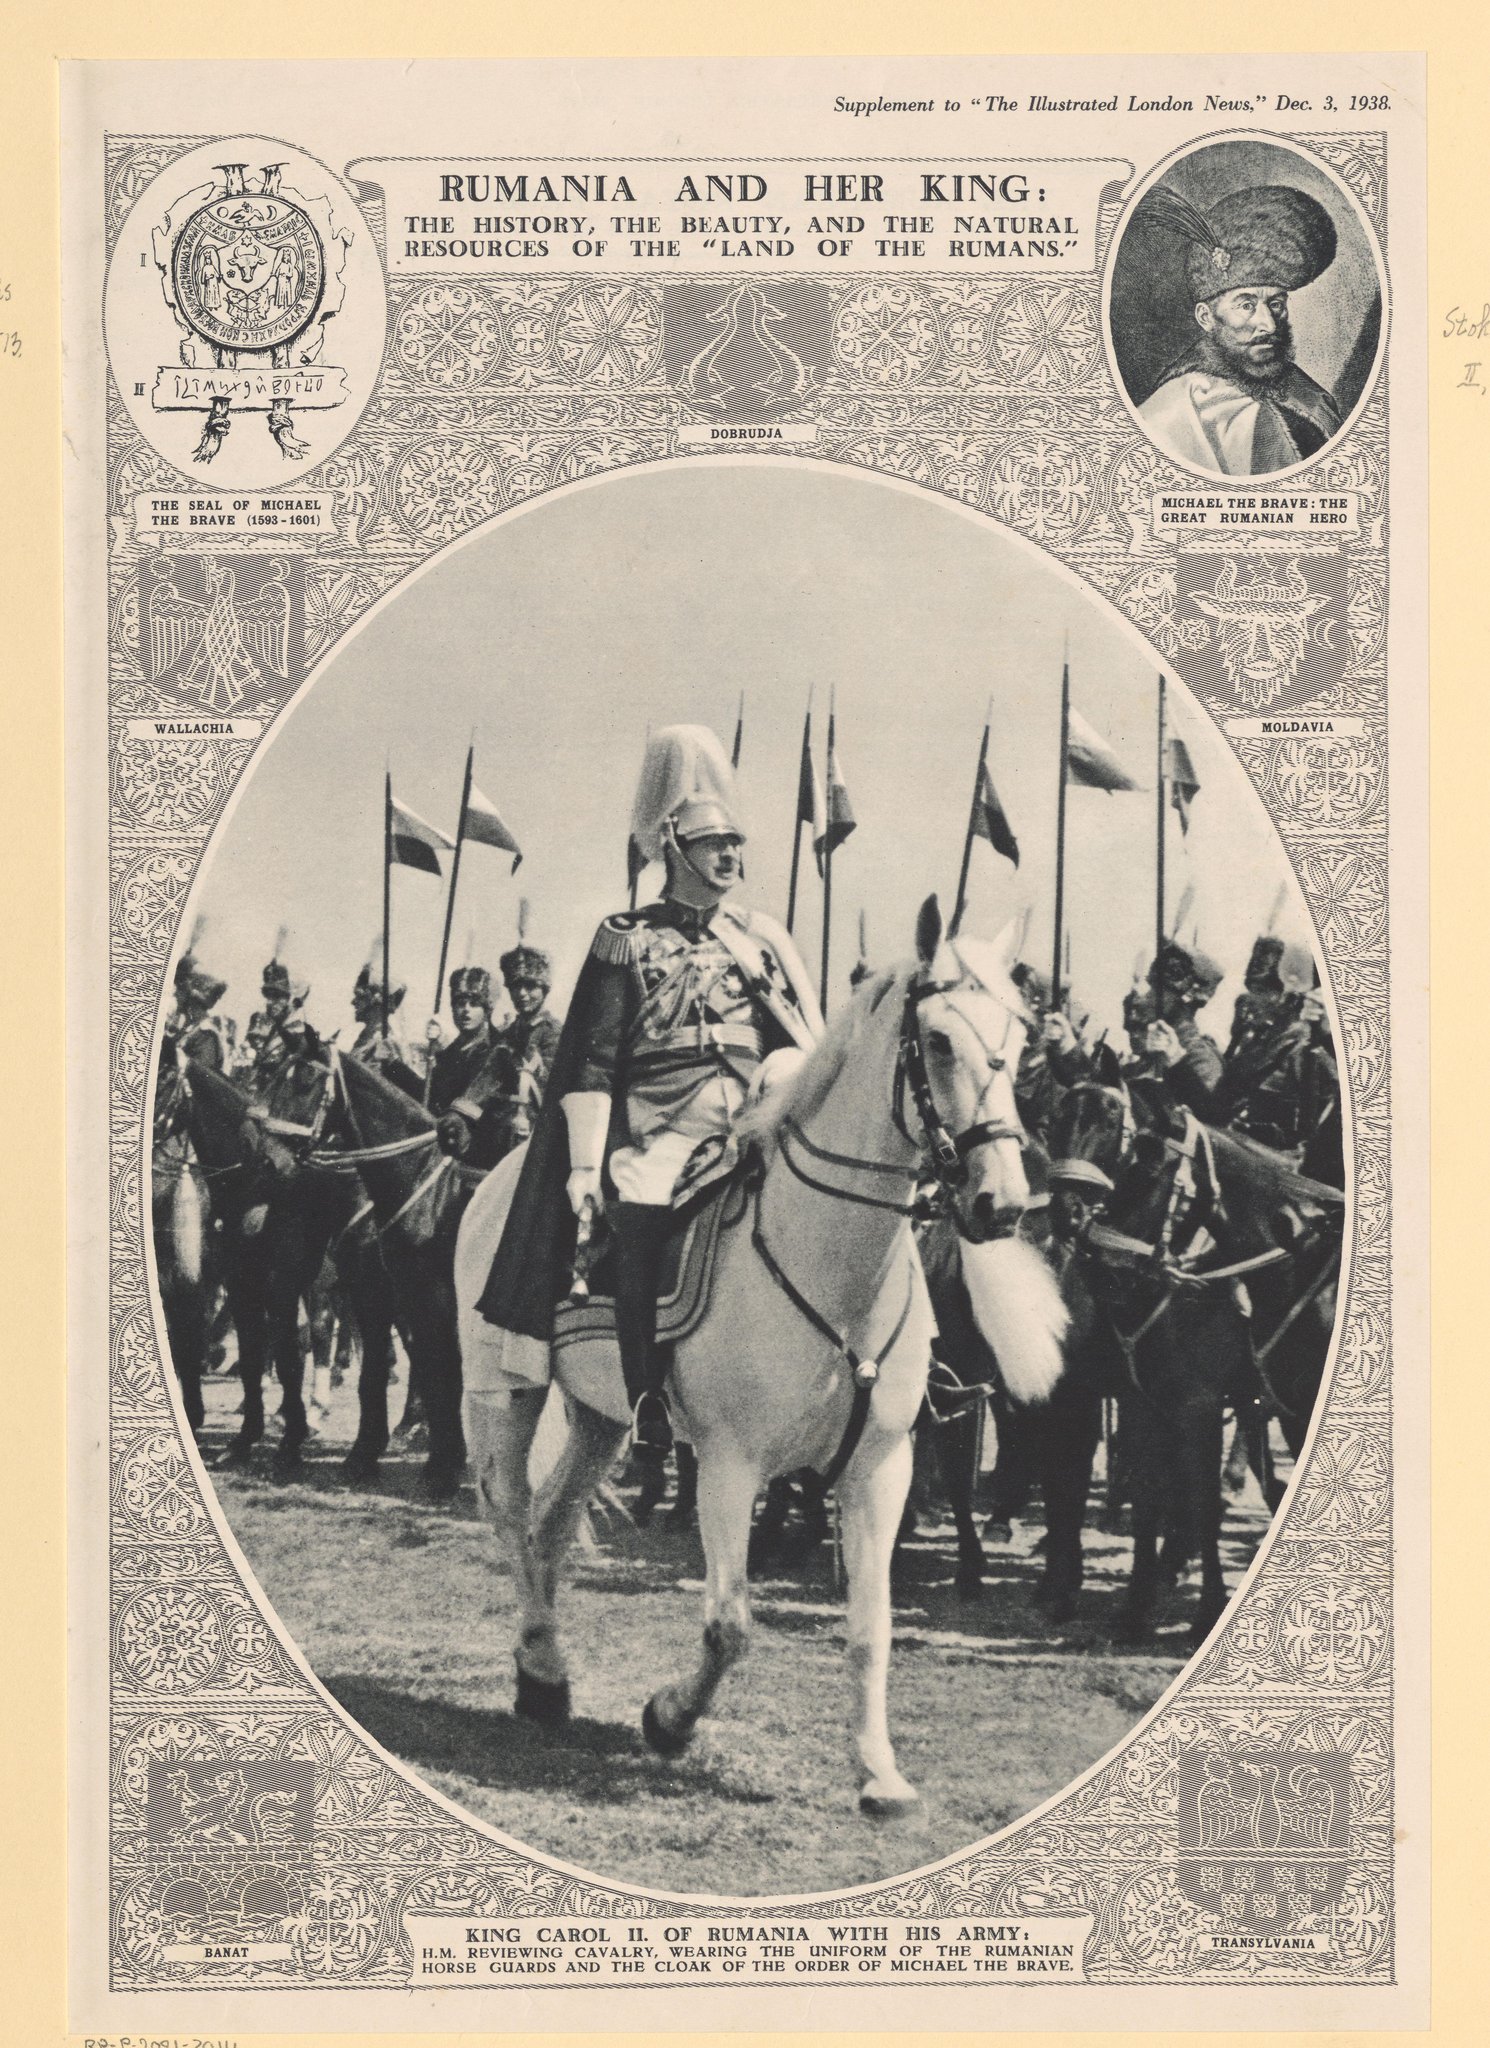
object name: photomechanical print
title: Portret van Carol I, koning van Roemenië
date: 1938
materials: paper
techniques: letterpress printing, rotogravure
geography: london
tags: historical persons, king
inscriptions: date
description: Prent als bijvoegsel van: The Illustrated London News, 3 december 1938.